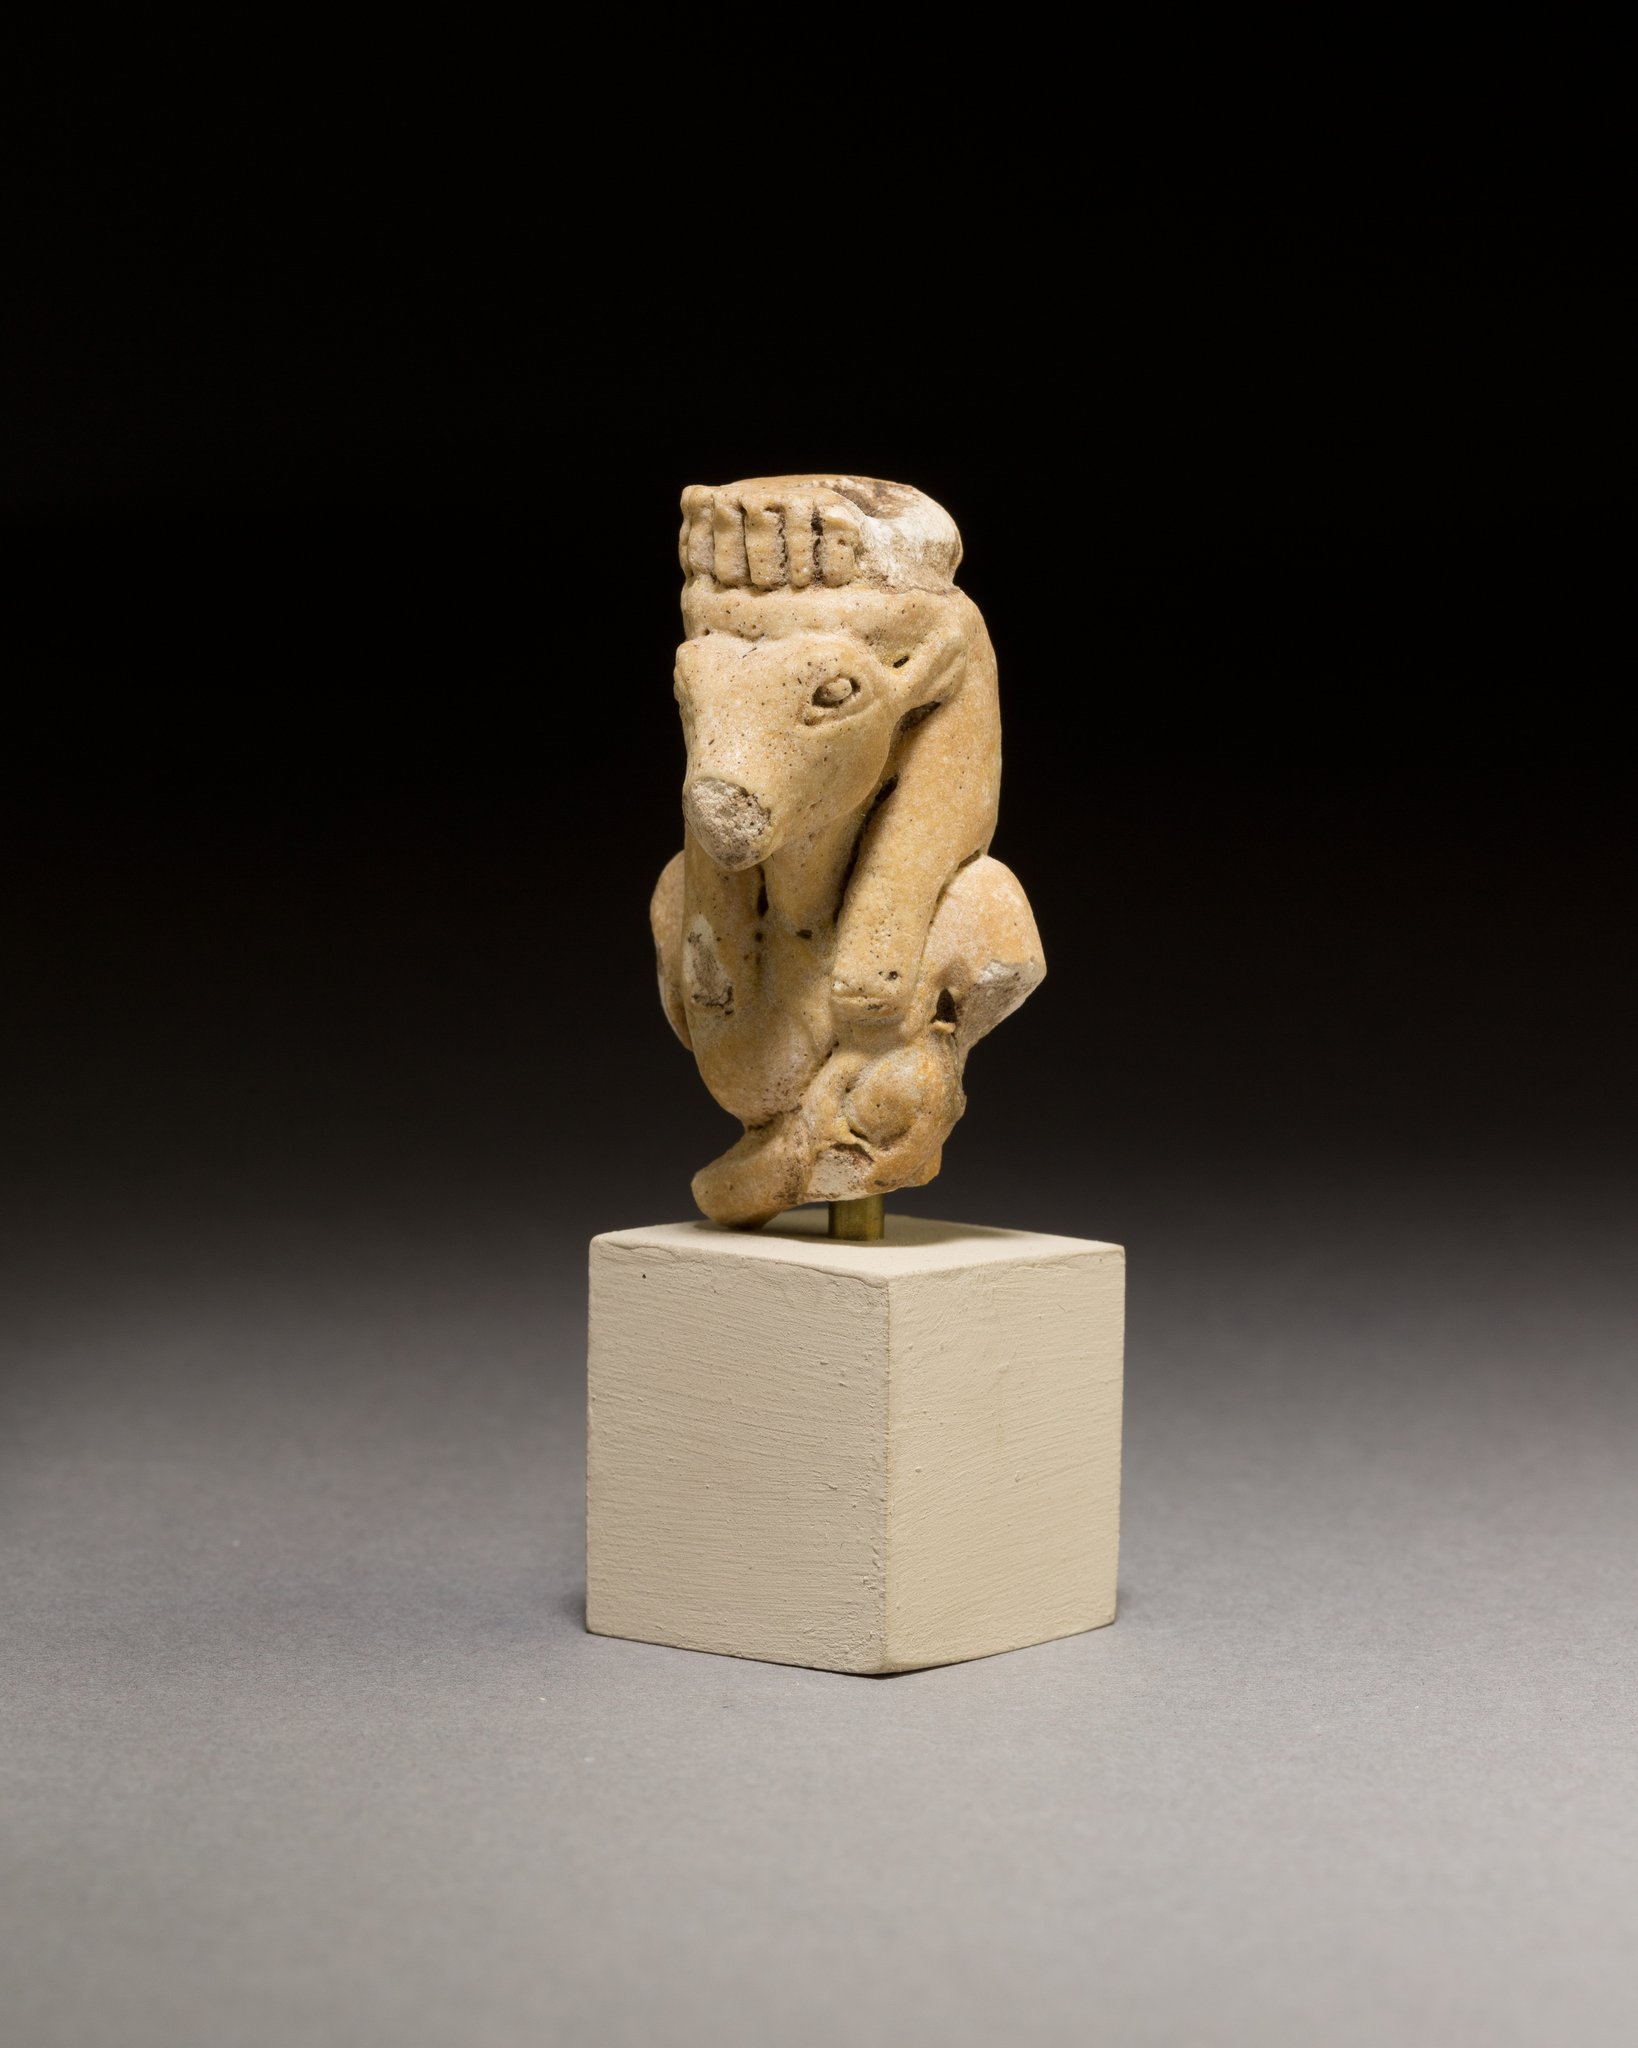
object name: bust, mother of the apis, headdress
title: Upper part of a statuette of the Mother of the Apis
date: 664-200 BCE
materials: faience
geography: egypt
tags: isis